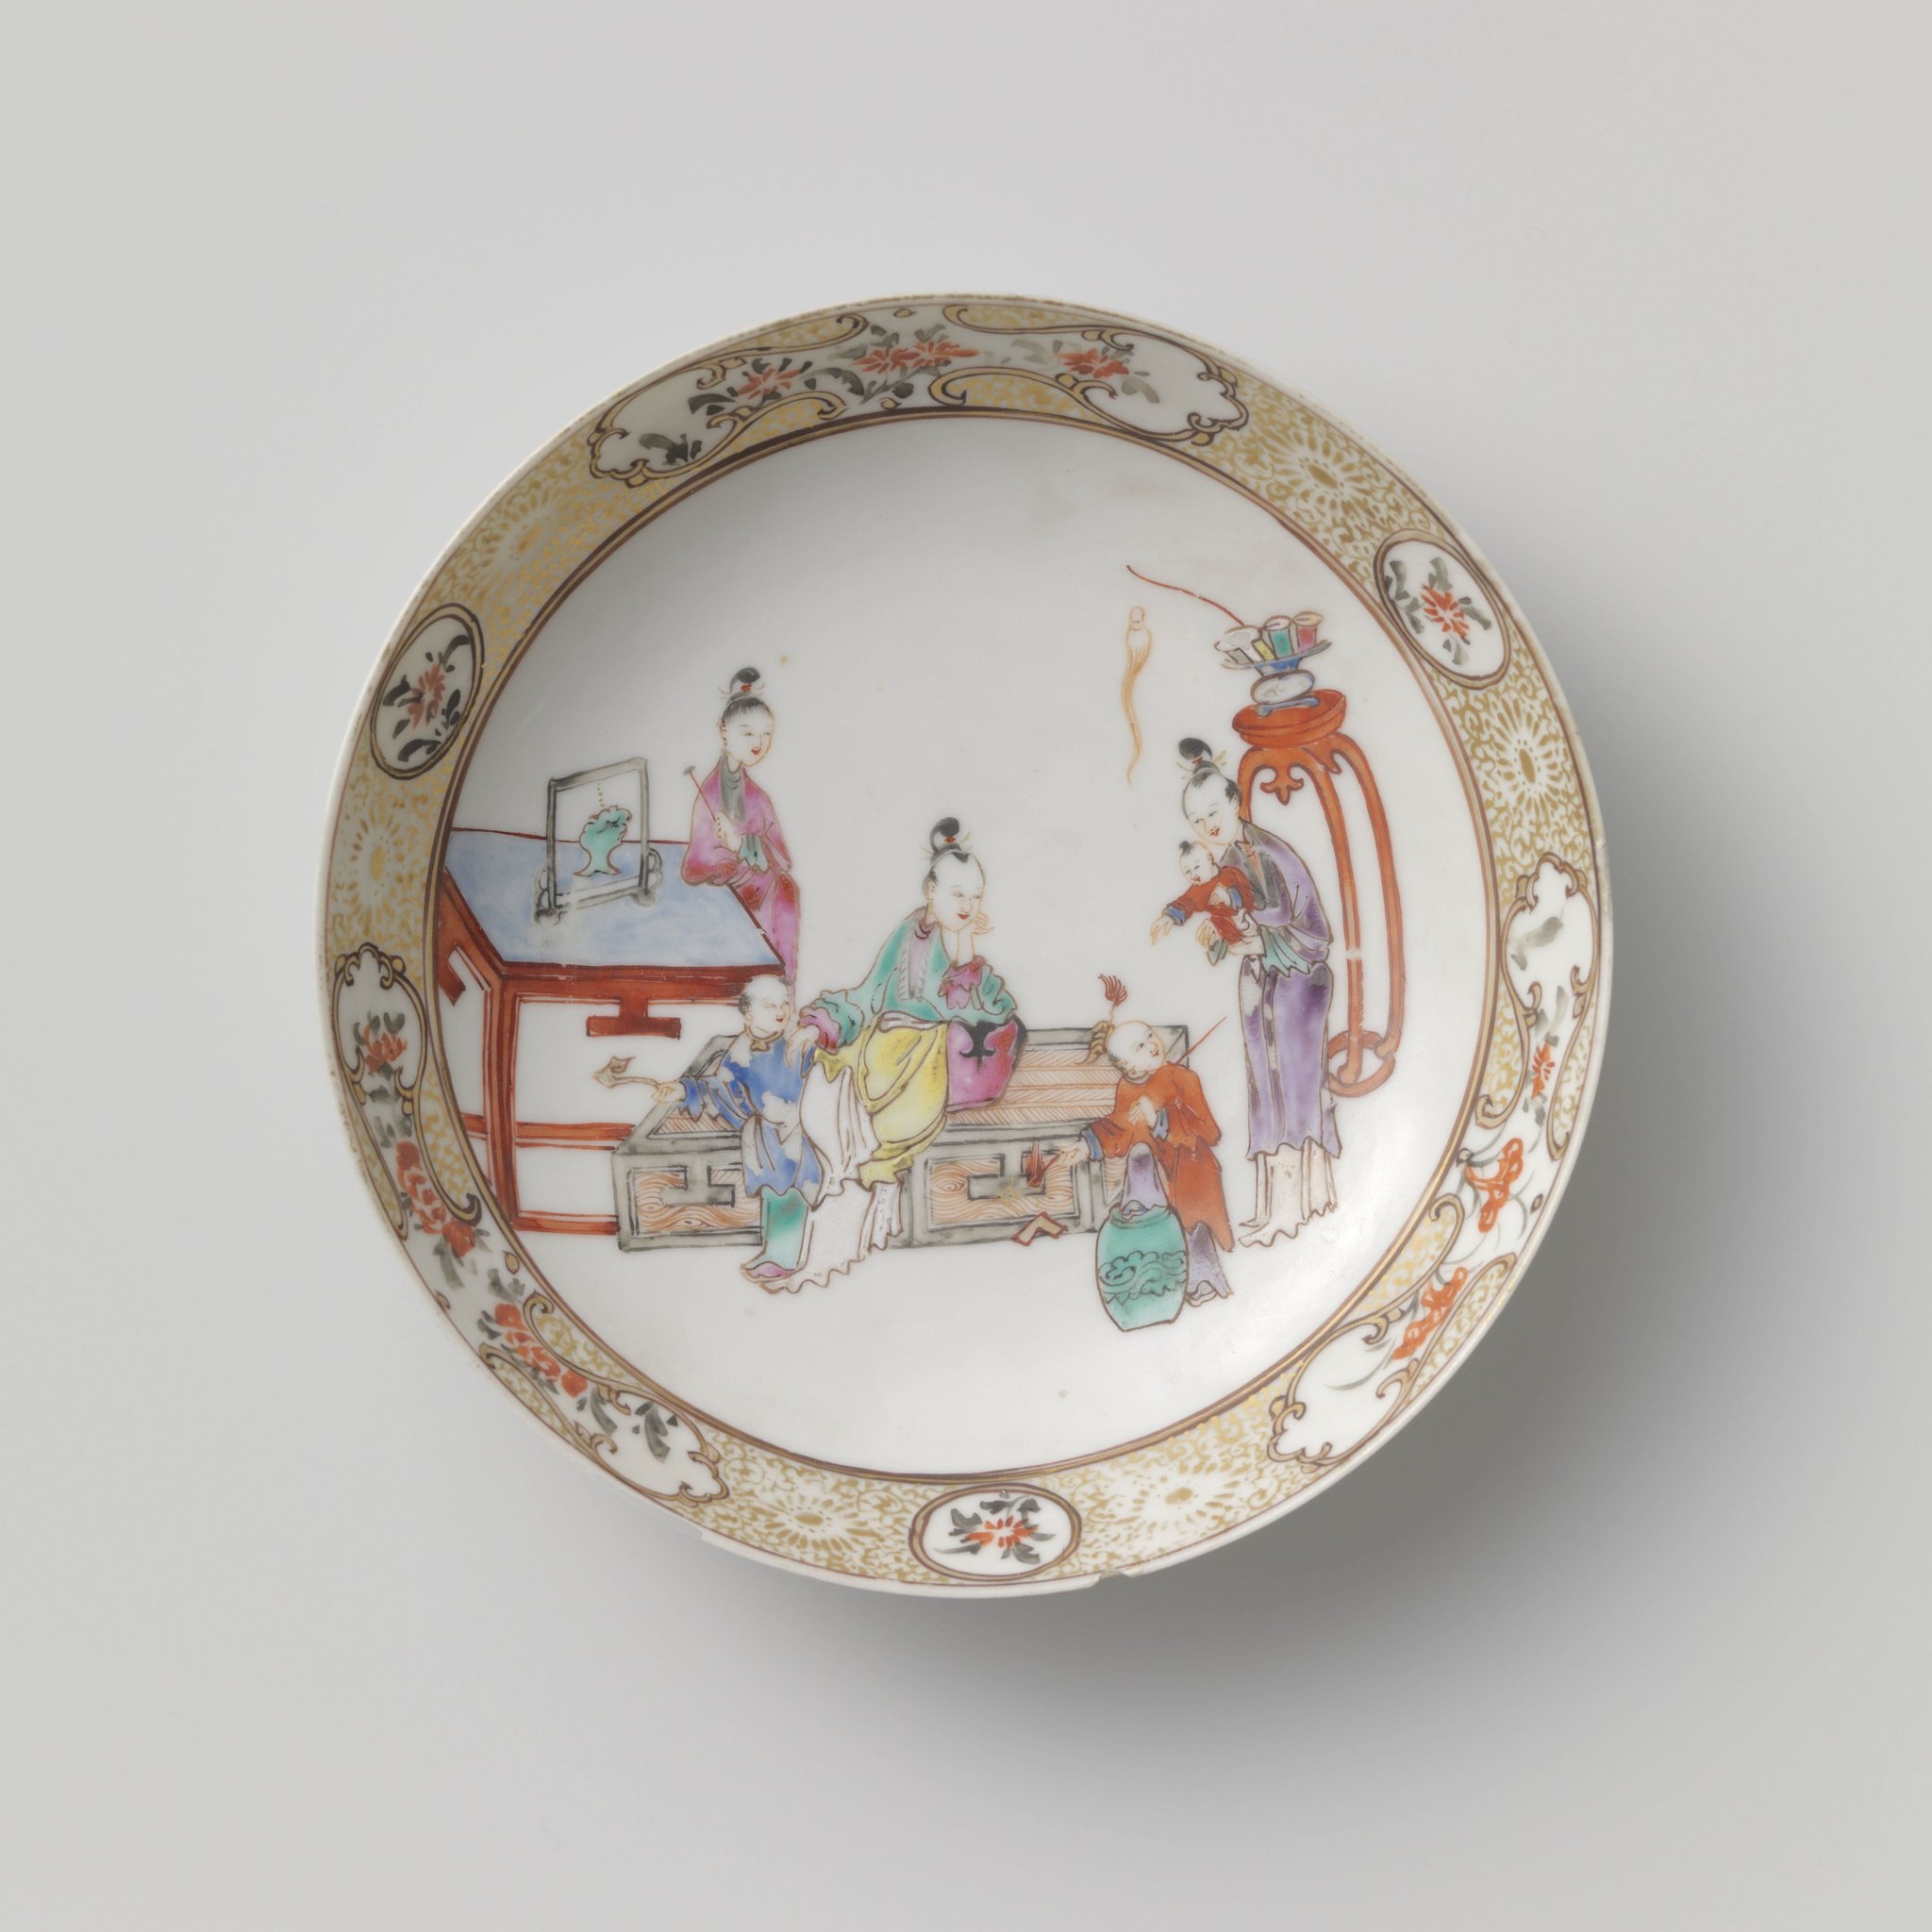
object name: dish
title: Saucer-dish with three women and children with precious objects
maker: Anonymous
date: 1740-1760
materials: glaze, gold, paint, porcelain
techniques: firing, gilding, turning, vitrification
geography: china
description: Schotel, met gouden rand en vignetten in het plat een Chinese familie.